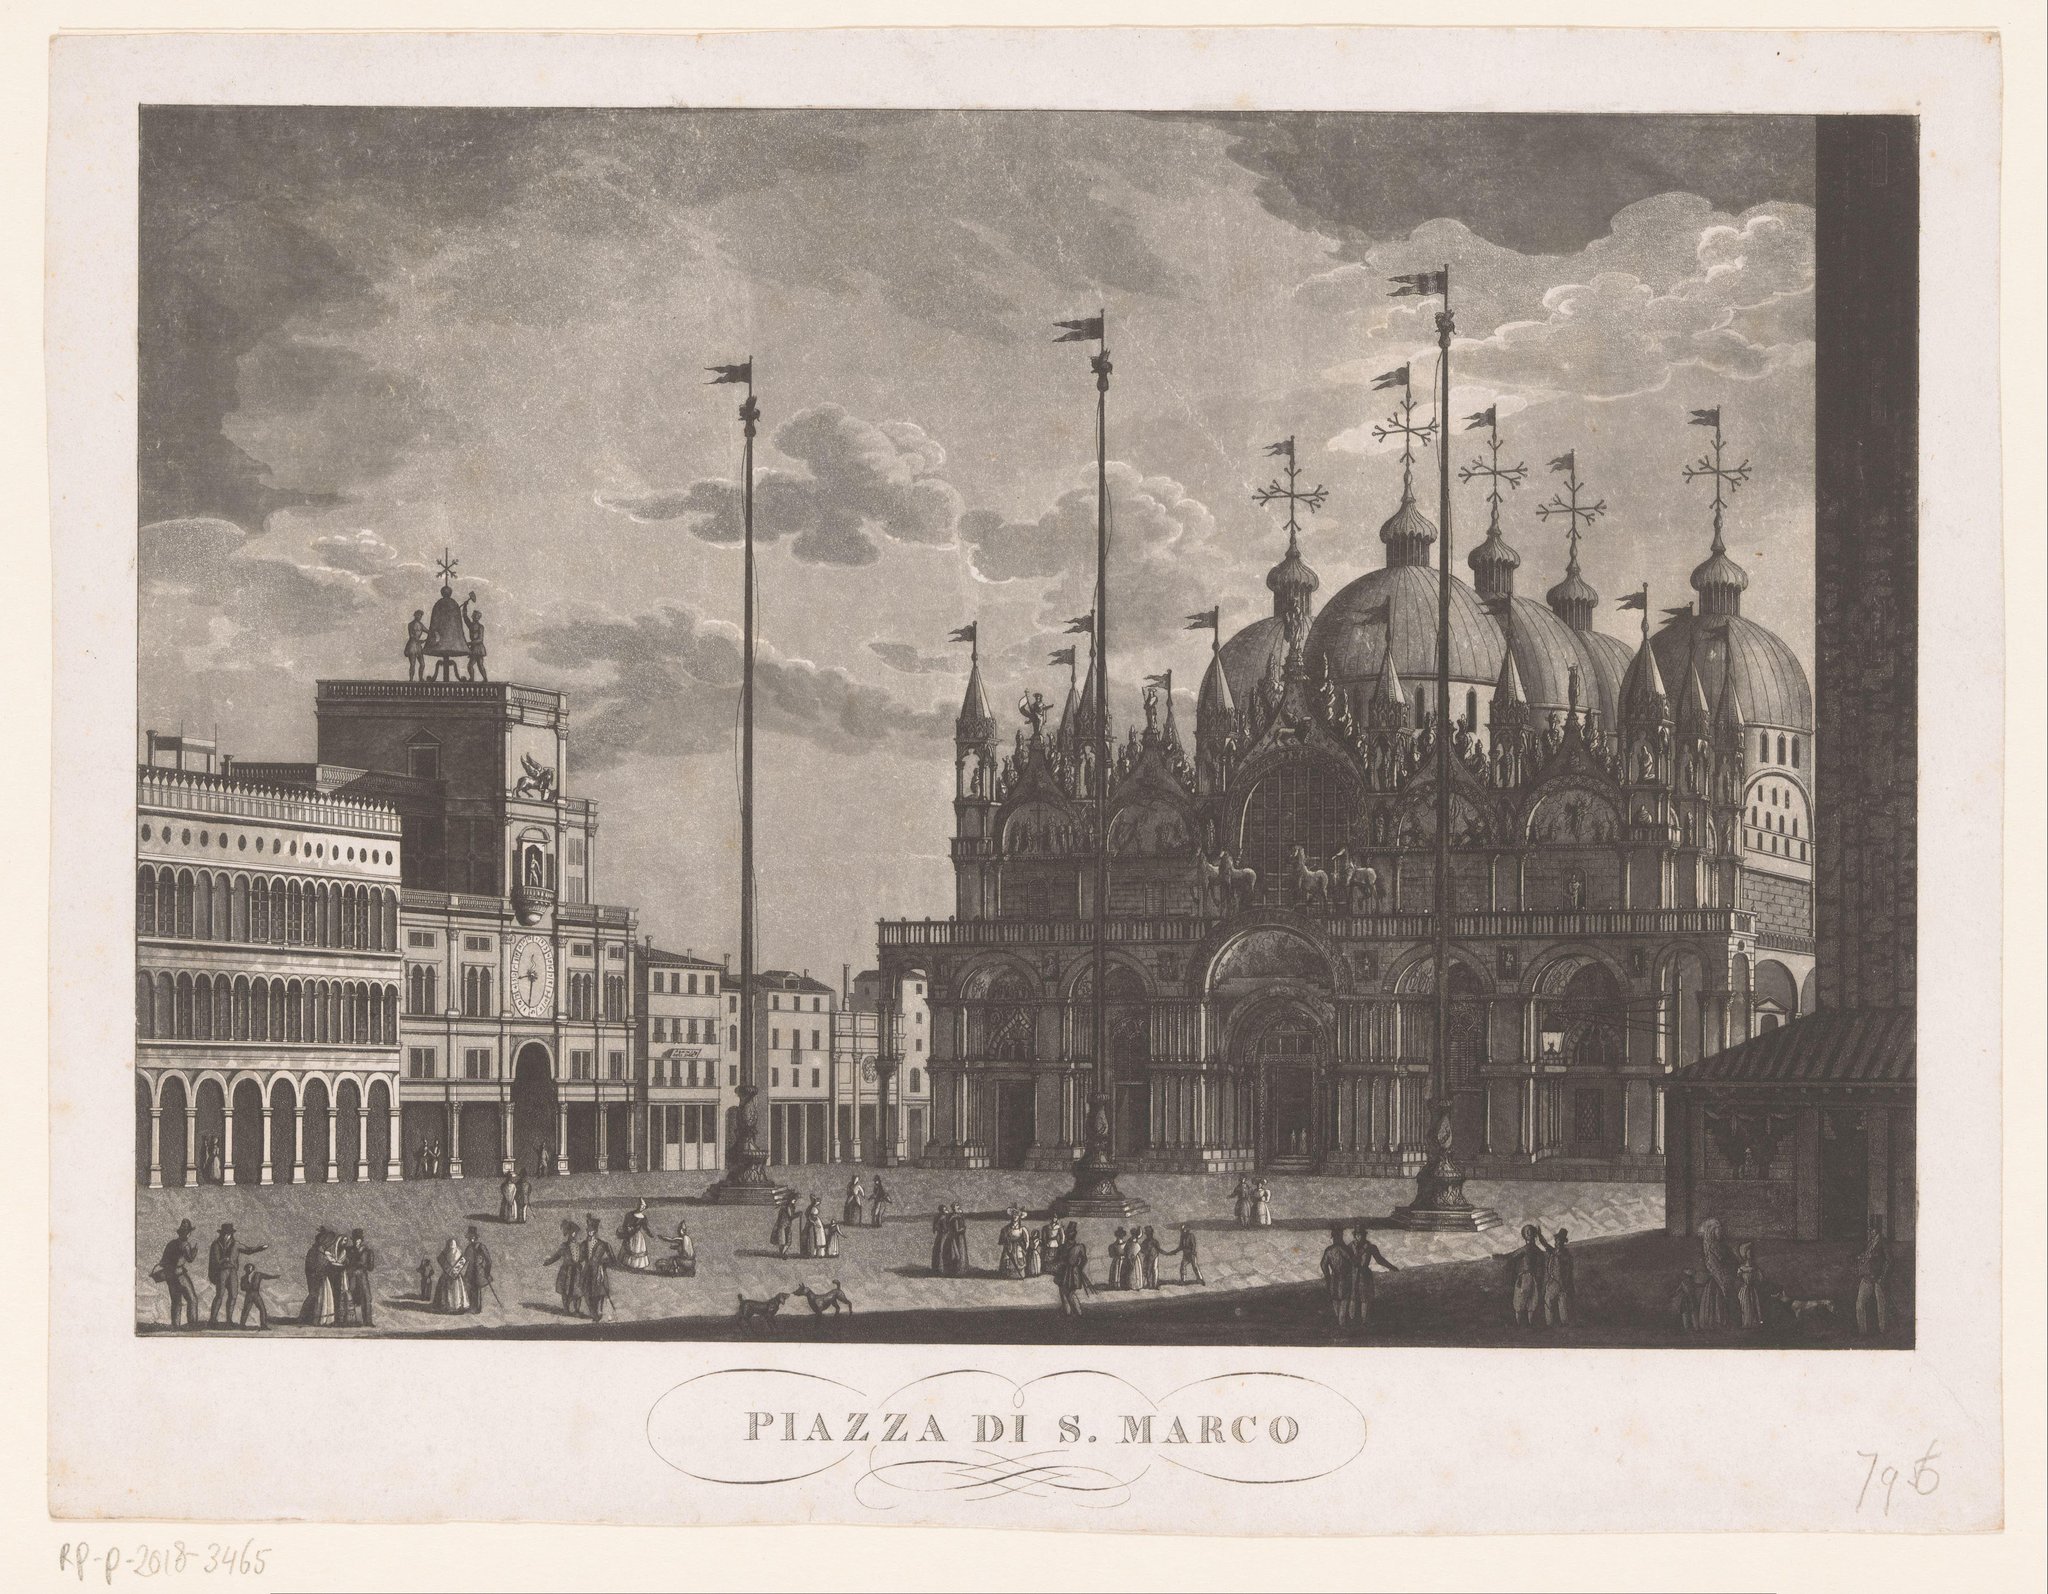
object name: print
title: Gezicht op de Basiliek van San Marco op het San Marcoplein te Venetië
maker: Anonymous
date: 1800-1850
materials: paper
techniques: aquatint, etching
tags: square, place, circus, etc., roman catholic church, parts of church exterior and annexes: façade